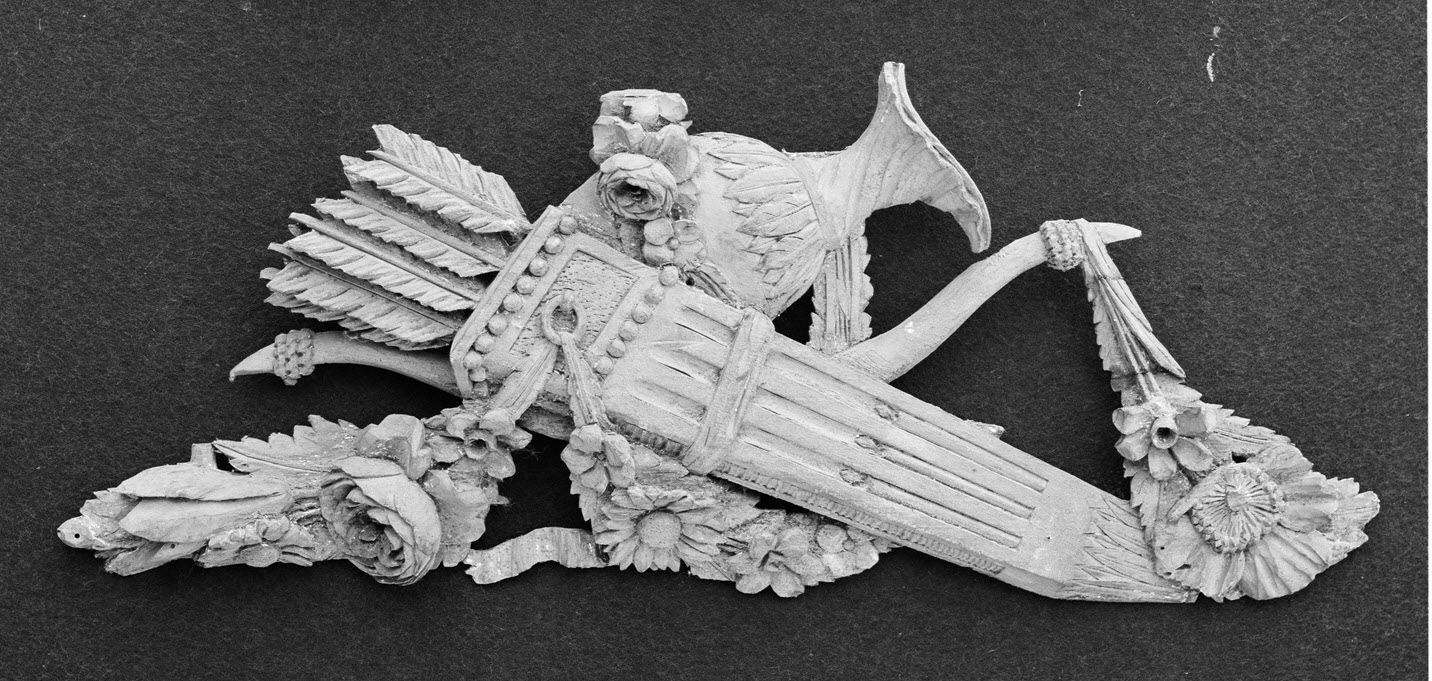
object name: trophy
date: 1701-1800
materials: gilt, wood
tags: bow and arrow,flowers,leaves,trophies